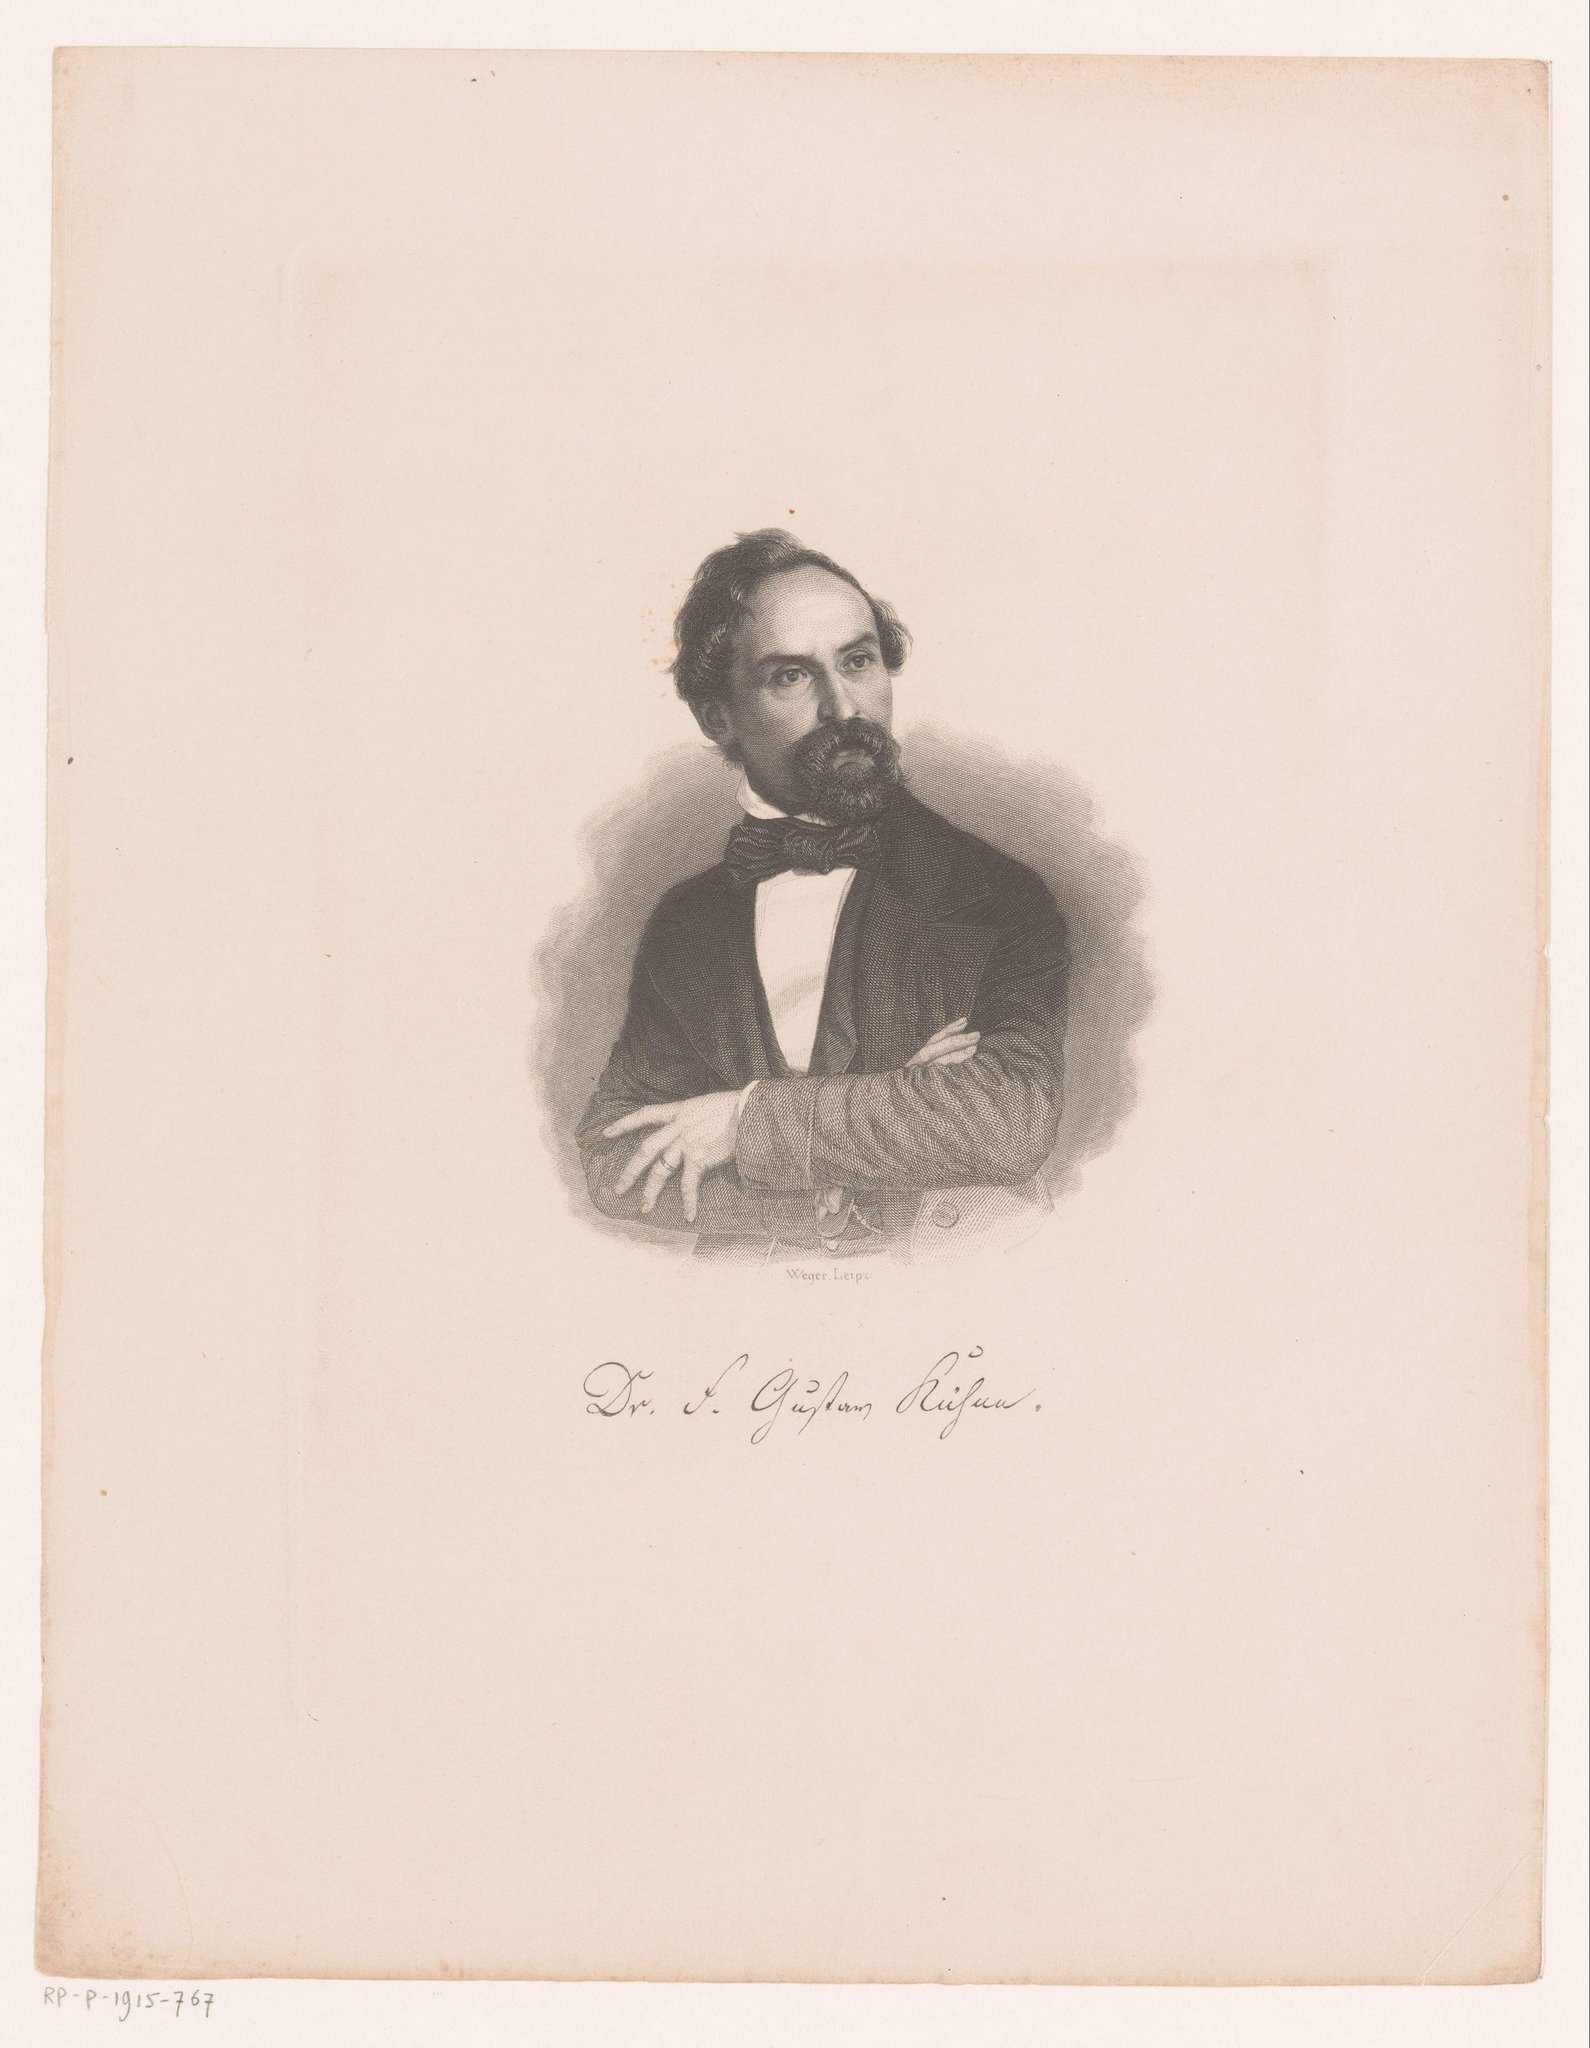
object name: print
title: Portret van Gustav Kühne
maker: august weger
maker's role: print maker, printer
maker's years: 1823-1892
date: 1849-1892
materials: paper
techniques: engraving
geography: leipzig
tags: historical persons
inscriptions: collector's mark: Lugt 2228